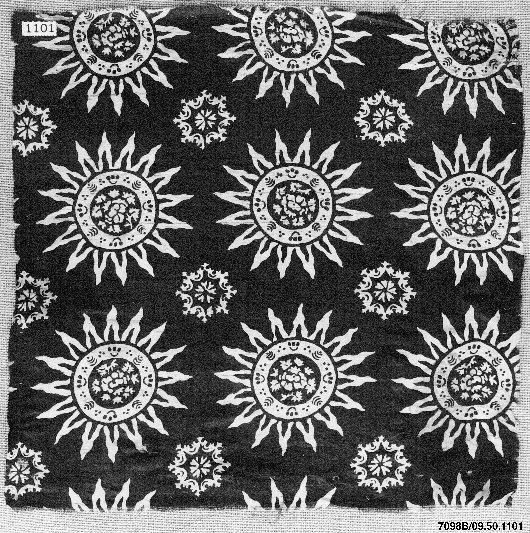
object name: textile fragment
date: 1801-1900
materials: silk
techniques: printing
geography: india